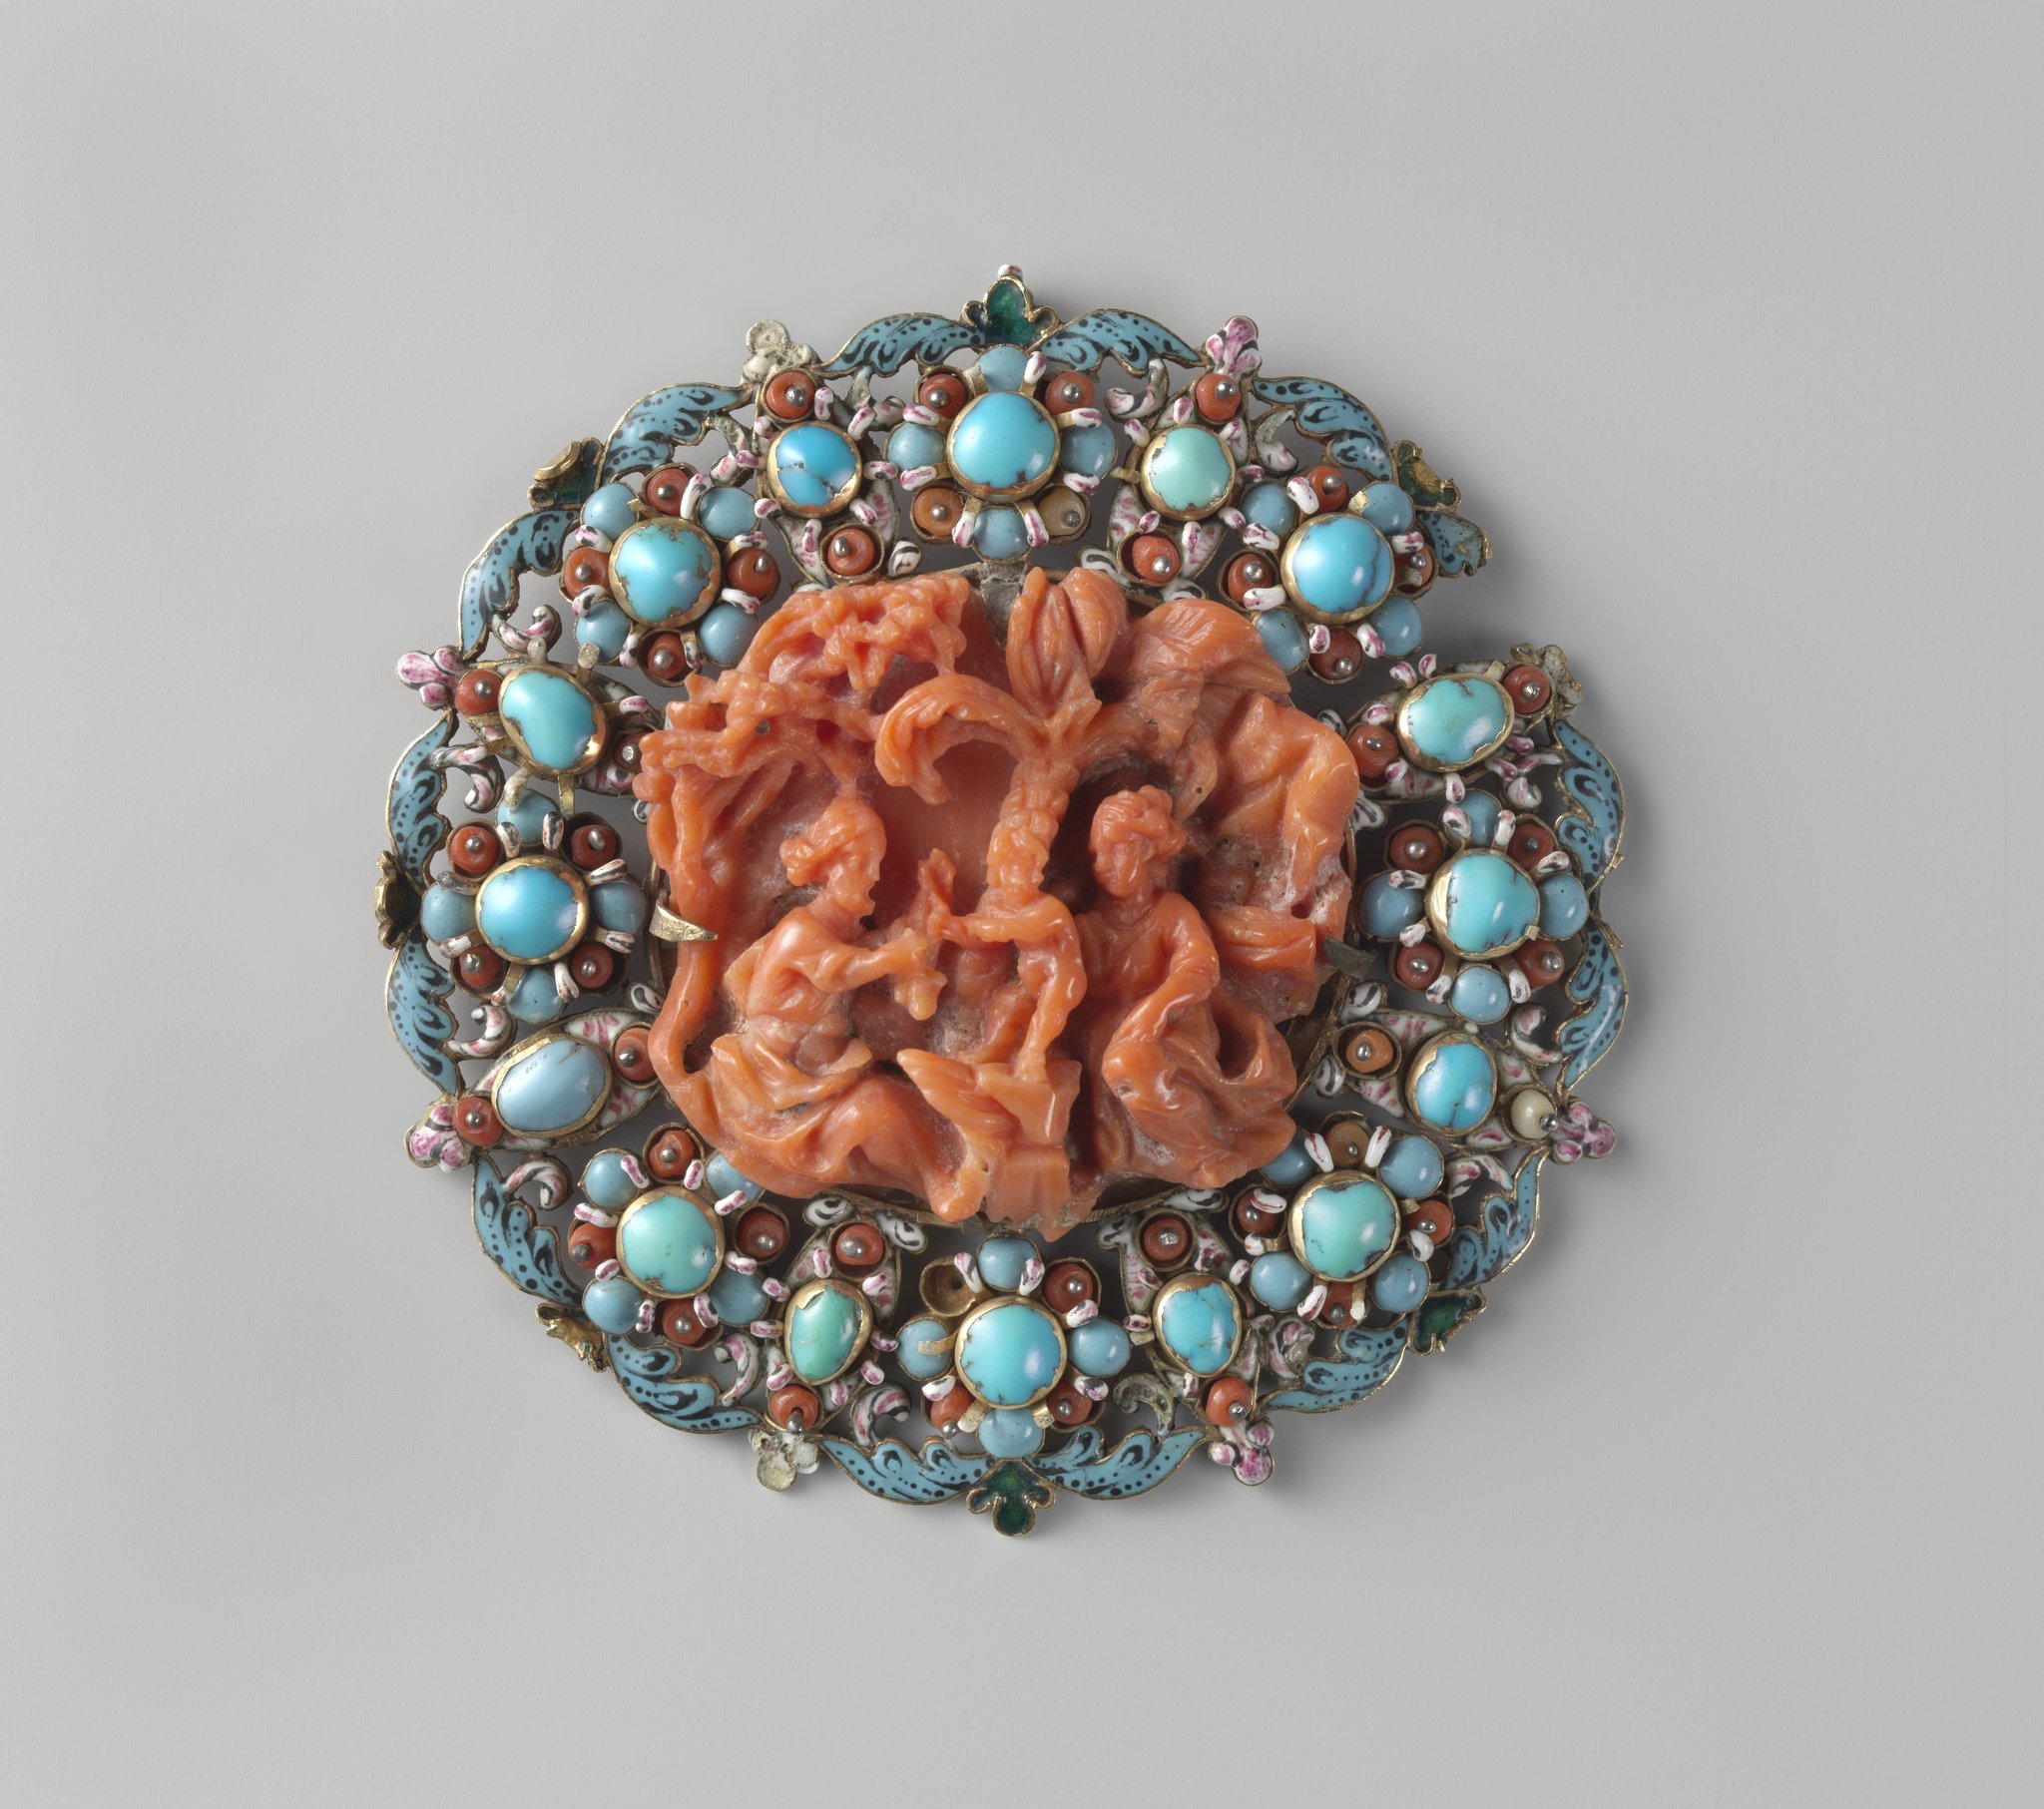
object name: pendant jewelry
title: Hanger met de rust op de vlucht naar Egypte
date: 1675-1700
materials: gold, coral, gemstone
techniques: enameling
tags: rest on the flight into egypt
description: Jewel, Rest on the Flight into Egypt. Gold, turquoise, blood coral and enamel. Netherlands or Spain, c. 1675-1700.